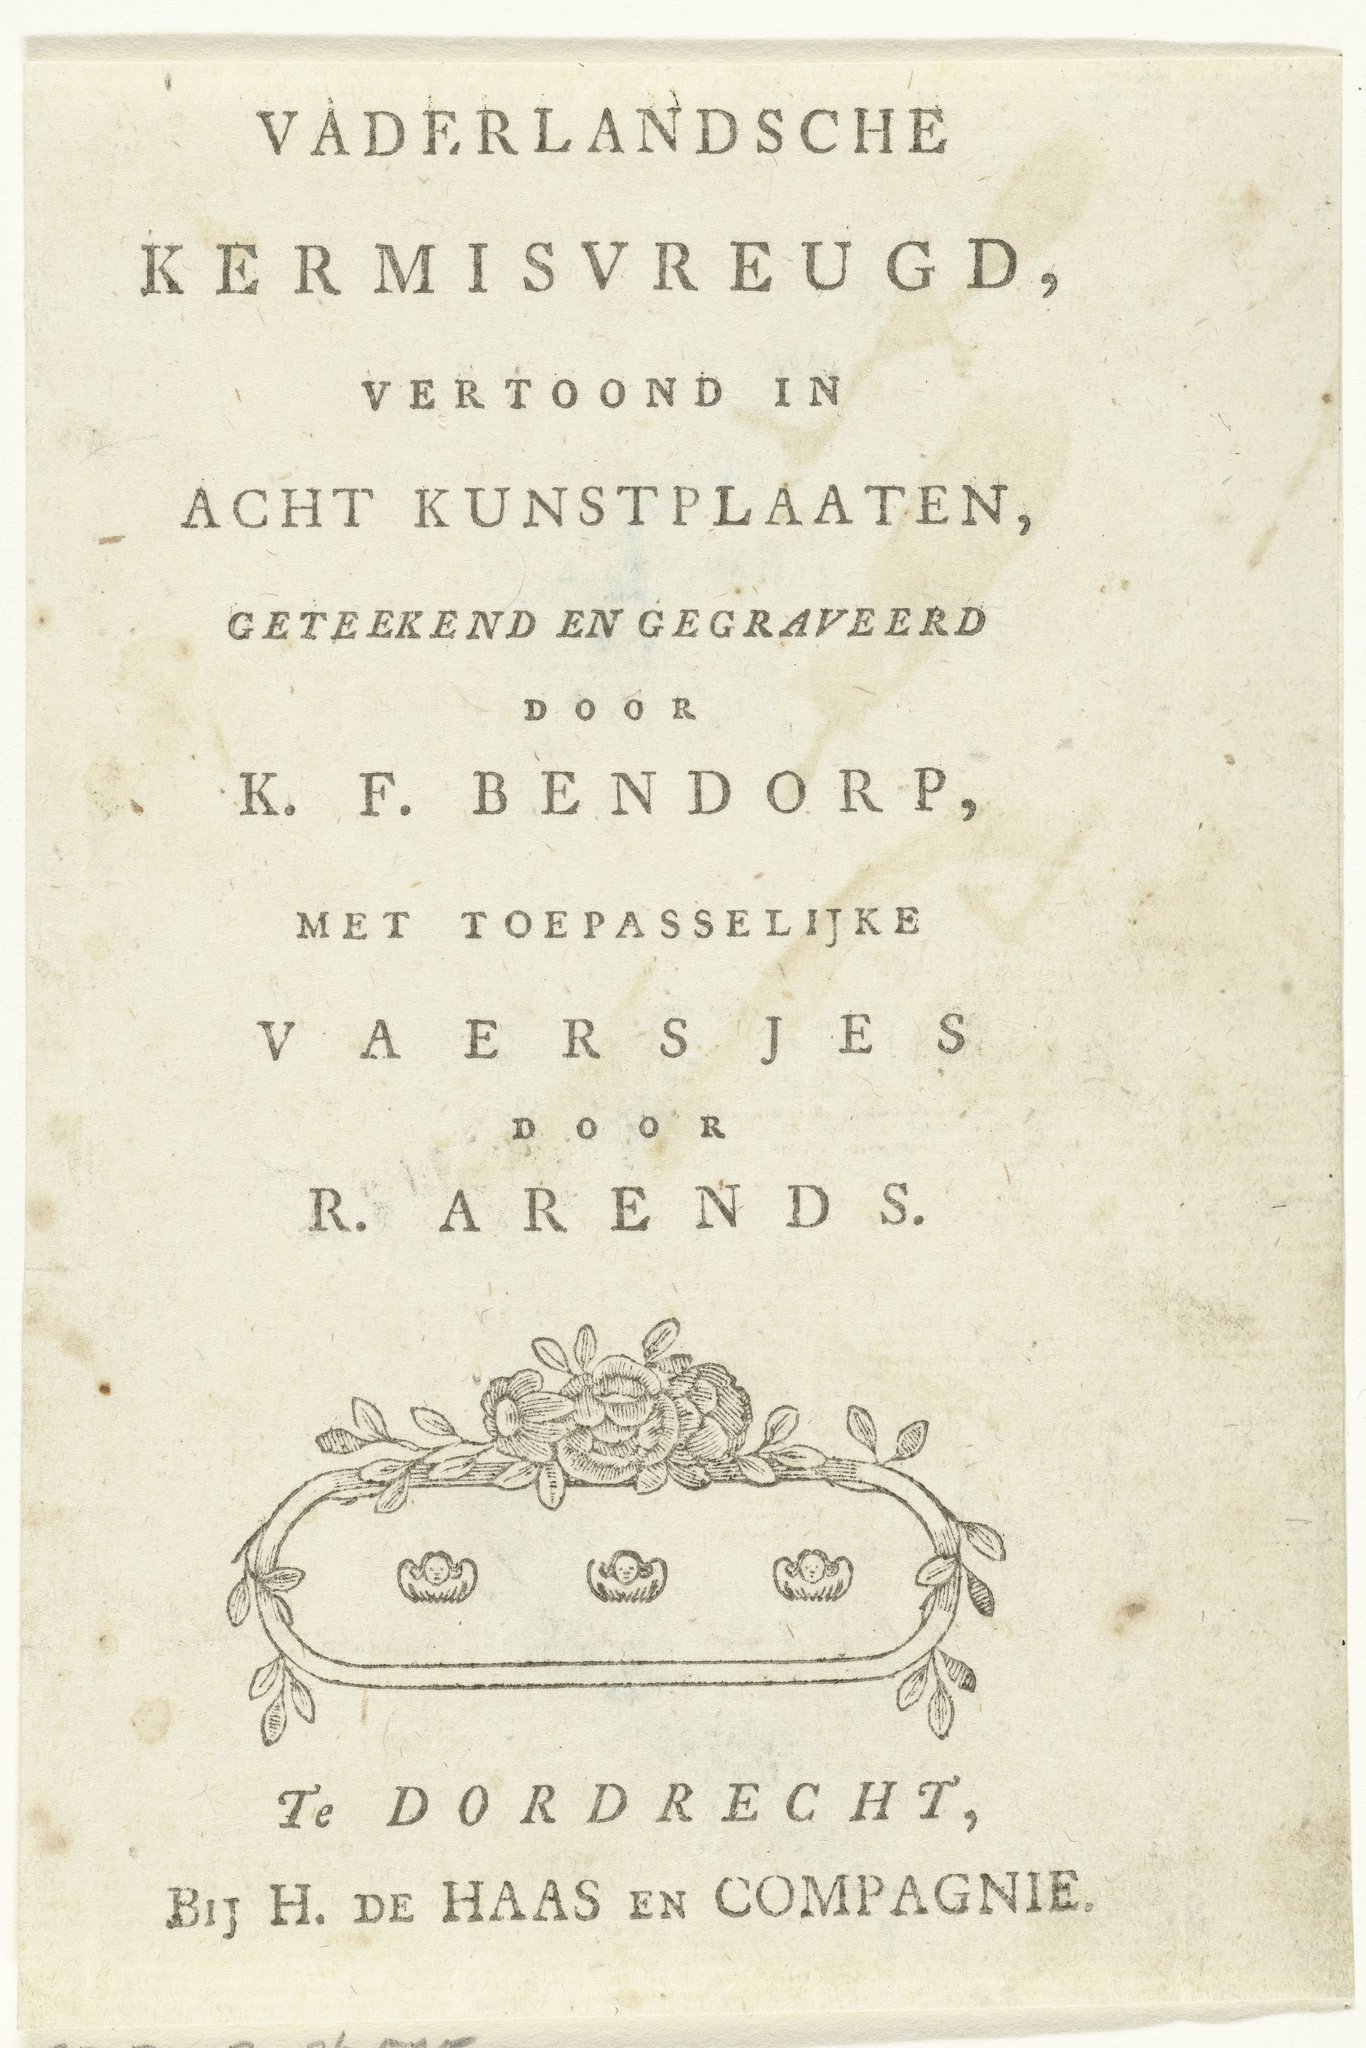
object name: print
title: Titelpagina voor: Vaderlandsche Kermisvreugd vertoond in acht kunstplaaten geteekend en gegraveerd door K.F. Bendorp, met toepasselijke Vaersjes door R. Arends, H. de Haas en Compagnie, Dordrecht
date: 1782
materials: paper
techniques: engraving, letterpress printing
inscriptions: collector's mark: Lugt 2760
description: Titelpagina voor: Vaderlandsche Kermisvreugd vertoond in acht kunstplaaten geteekend en gegraveerd door K.F. Bendorp, met toepasselijke Vaersjes door R. Arends, H. de Haas en Compagnie (uitgever) Dordrecht 1782